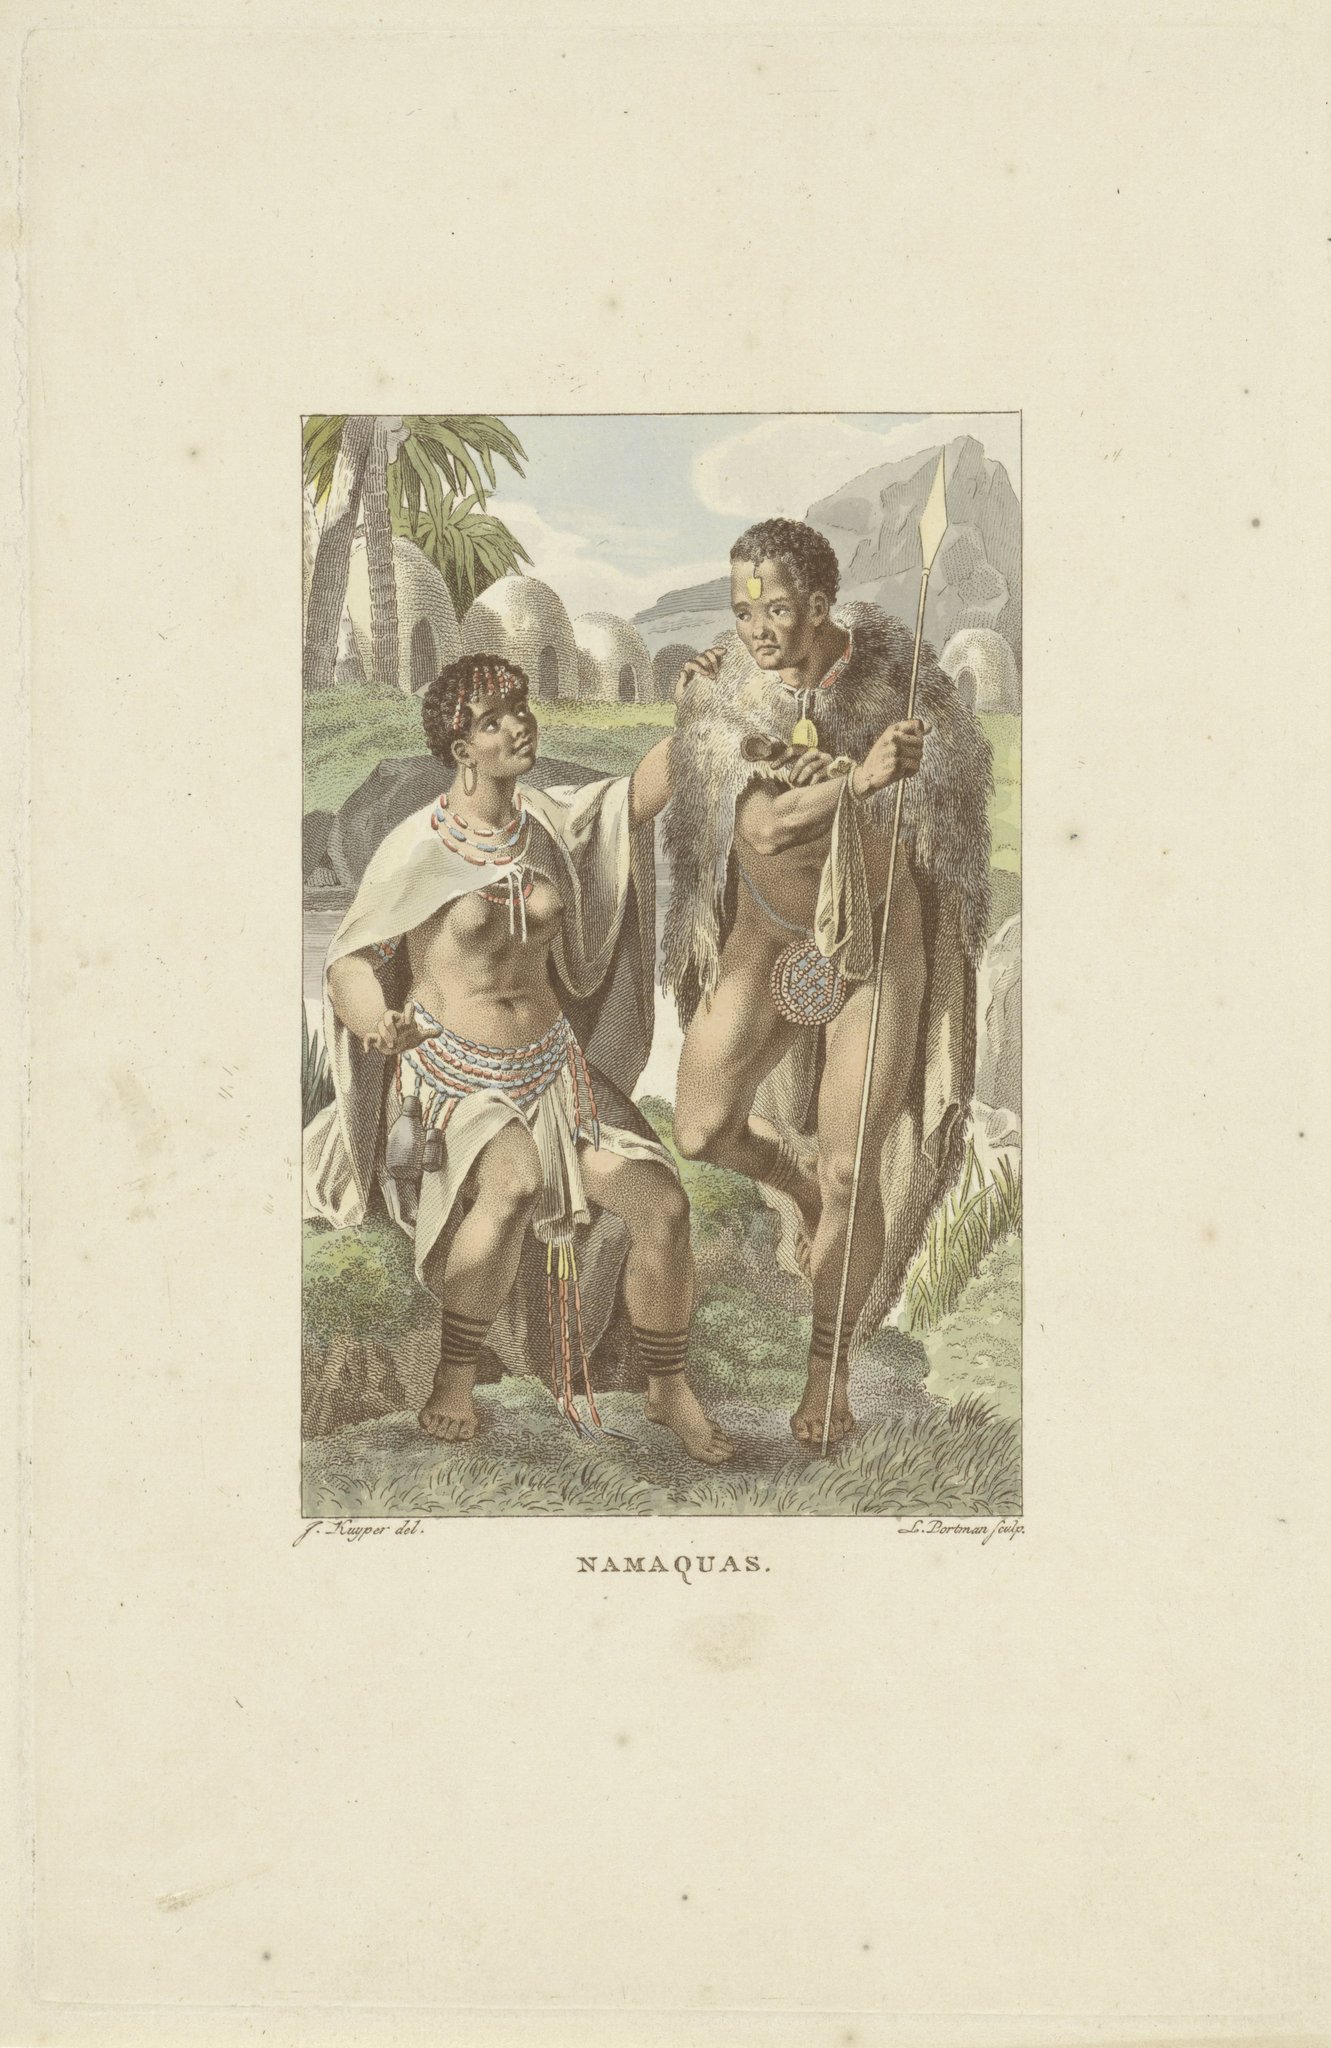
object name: print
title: Nama van Zuidelijk Afrika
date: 1806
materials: paper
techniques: etching, hand coloring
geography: amsterdam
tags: human races; peoples; nationalities (+ costume), couple of lovers, khoikhoi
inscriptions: collector's mark: Lugt 2228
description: Illustratie uit: Stuart, Martinus. De mensch, zoo als hij voorkomt op den bekenden aardbol, deel V, p. 98. Amsterdam: Johannes Allart, 1806.